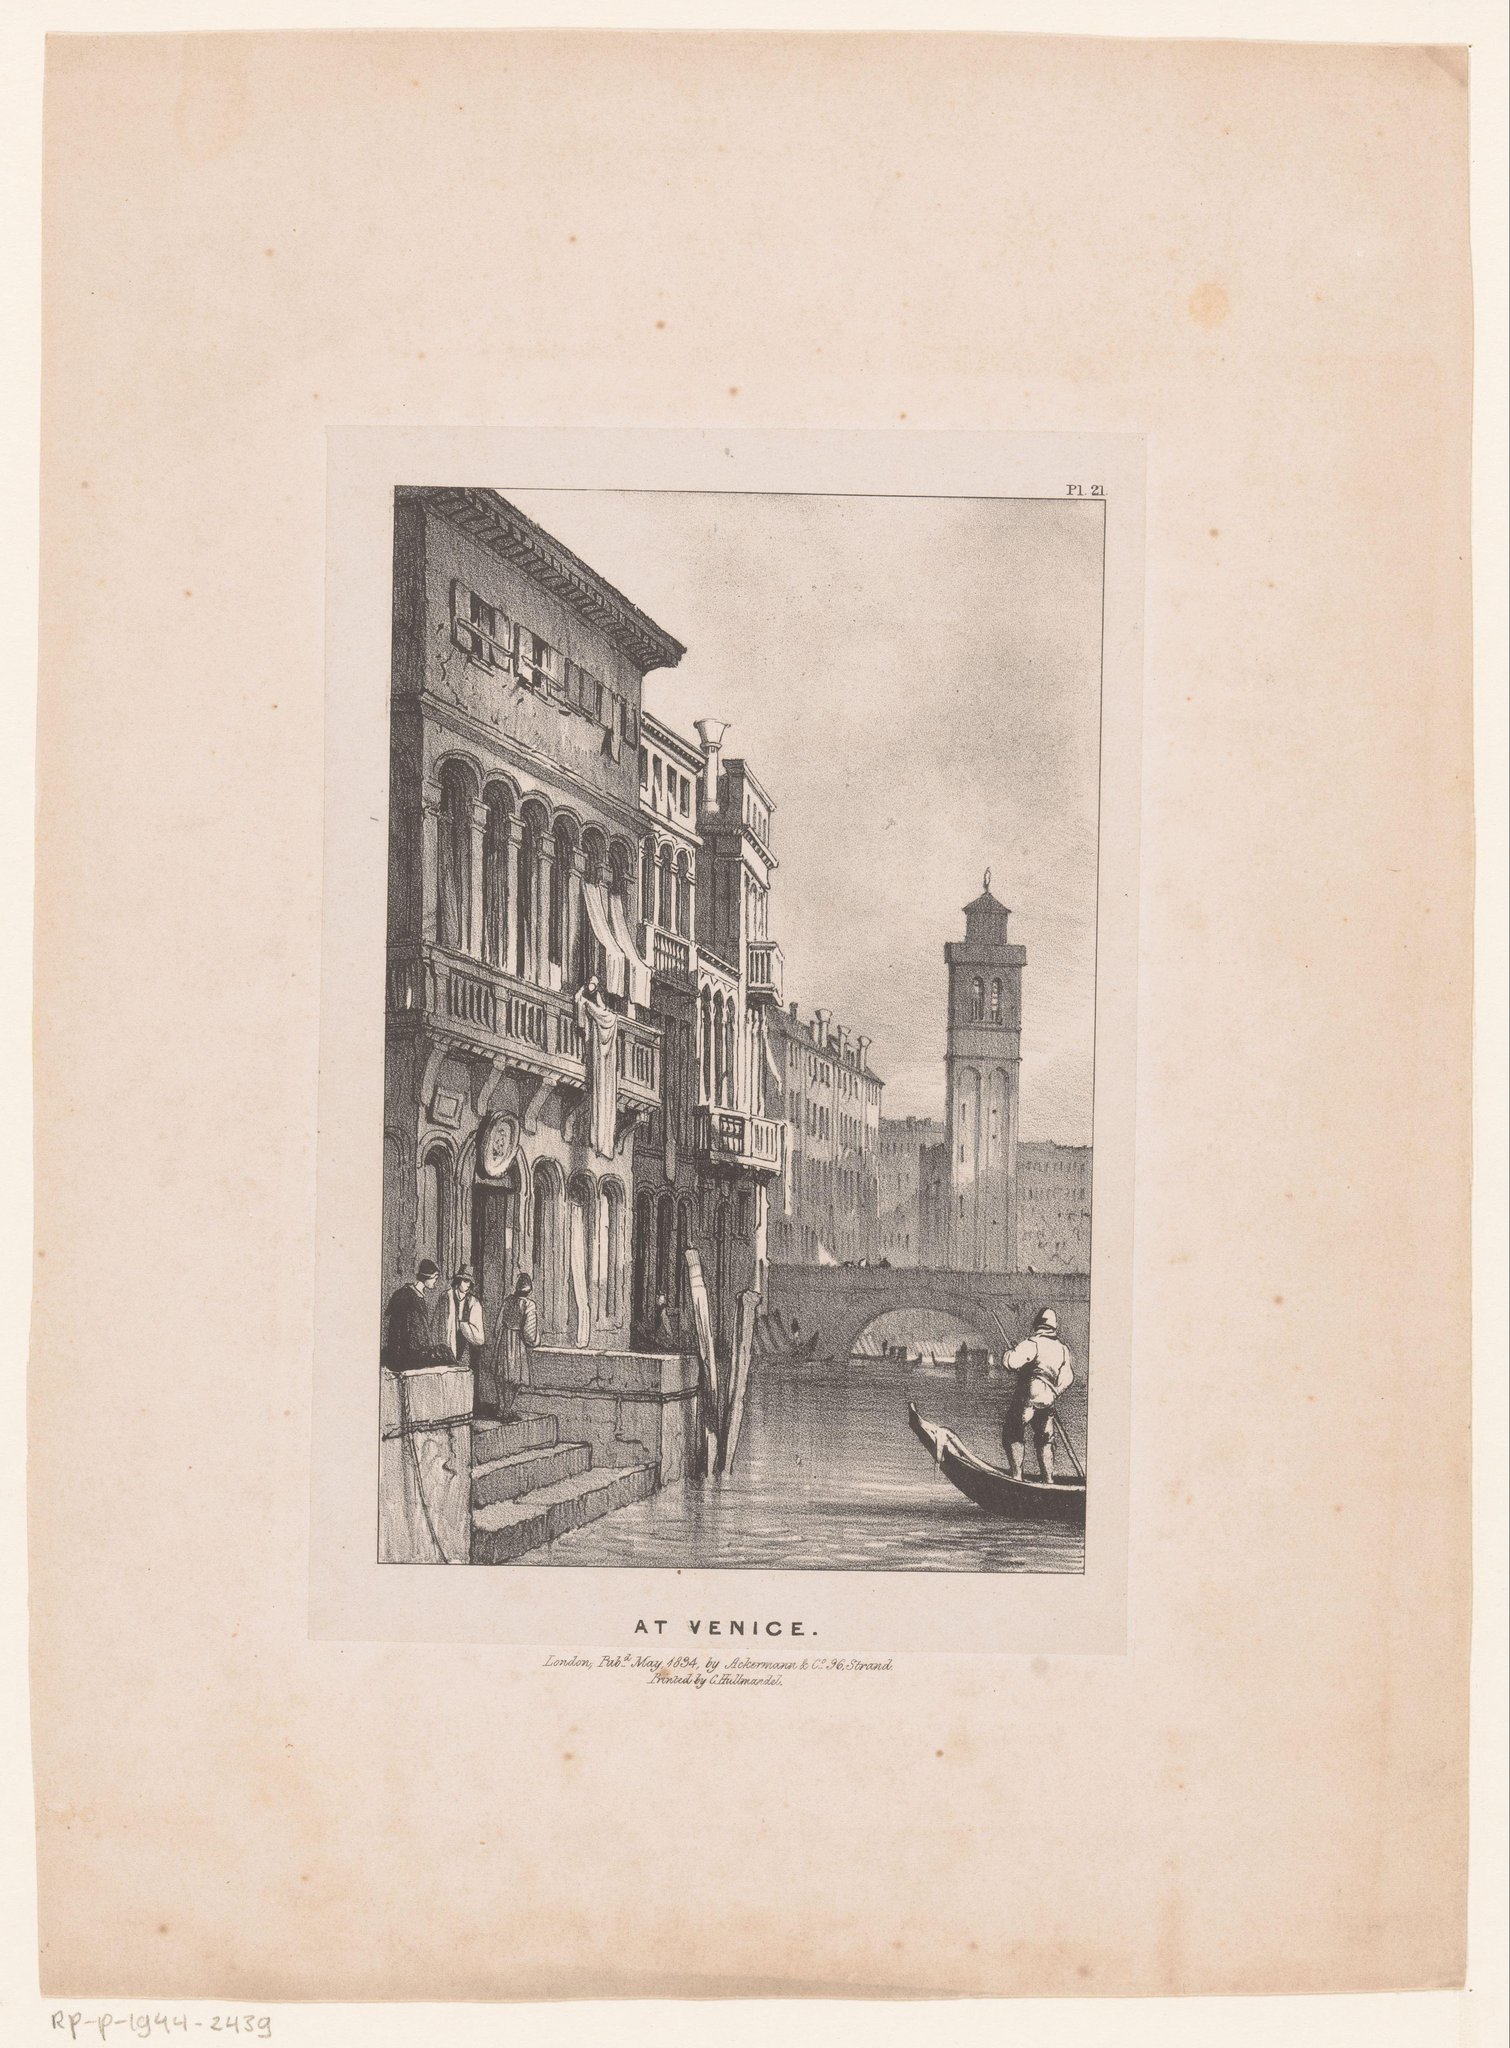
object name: print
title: Gezicht op de Canale di Cannaregio te Venetië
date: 1834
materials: paper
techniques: lithograph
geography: london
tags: canals, waters (in city), bridge in city across river, canal, etc., venice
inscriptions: collector's mark: Lugt 2228